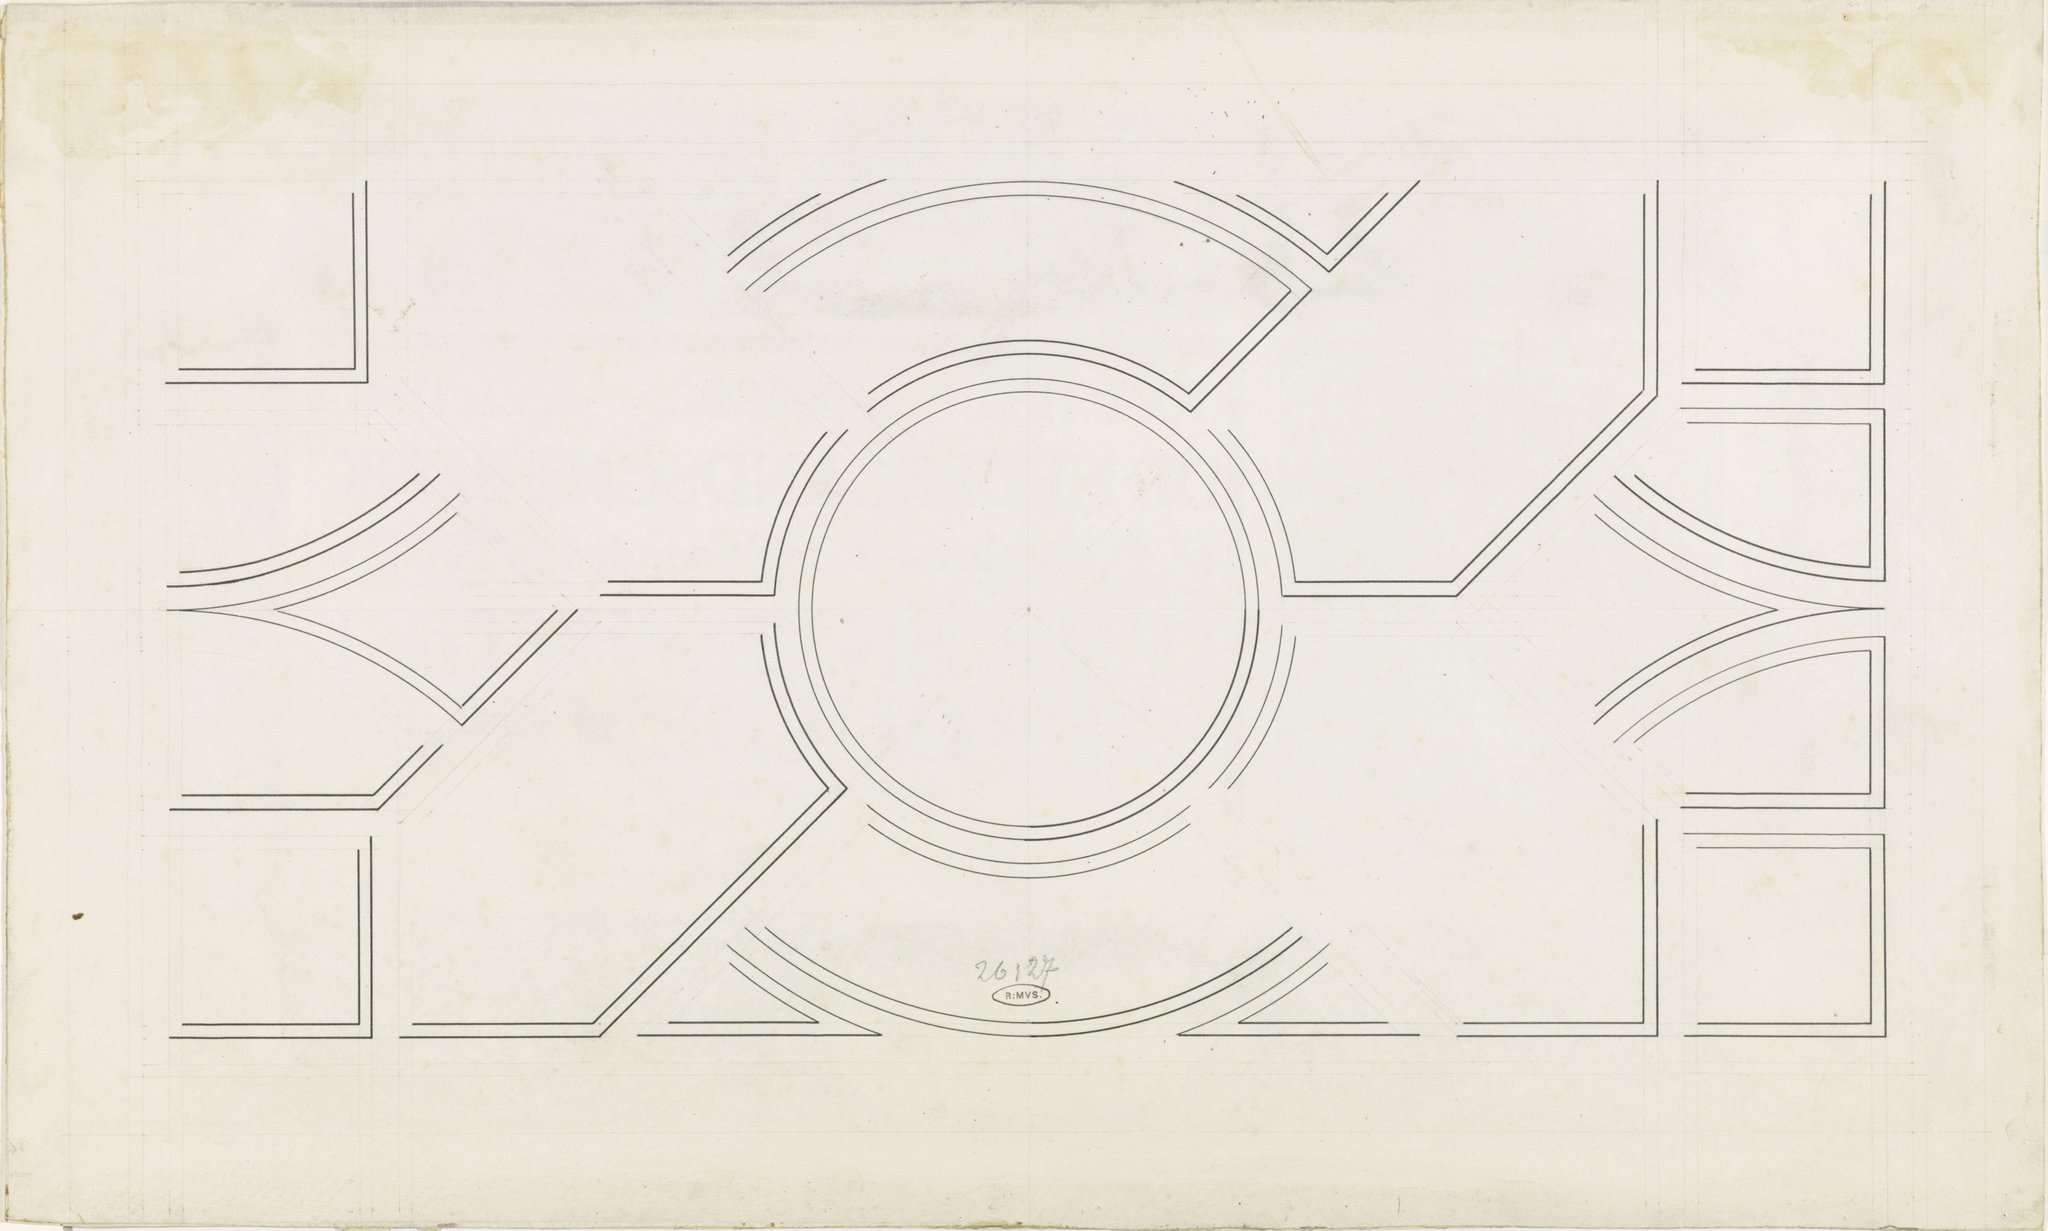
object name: design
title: Ontwerp voor een bankbiljet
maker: antoon derkinderen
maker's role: draughtsman, painter, print maker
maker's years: 1859-1925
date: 1912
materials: ink, paper, pencil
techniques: pen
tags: bank-note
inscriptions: date